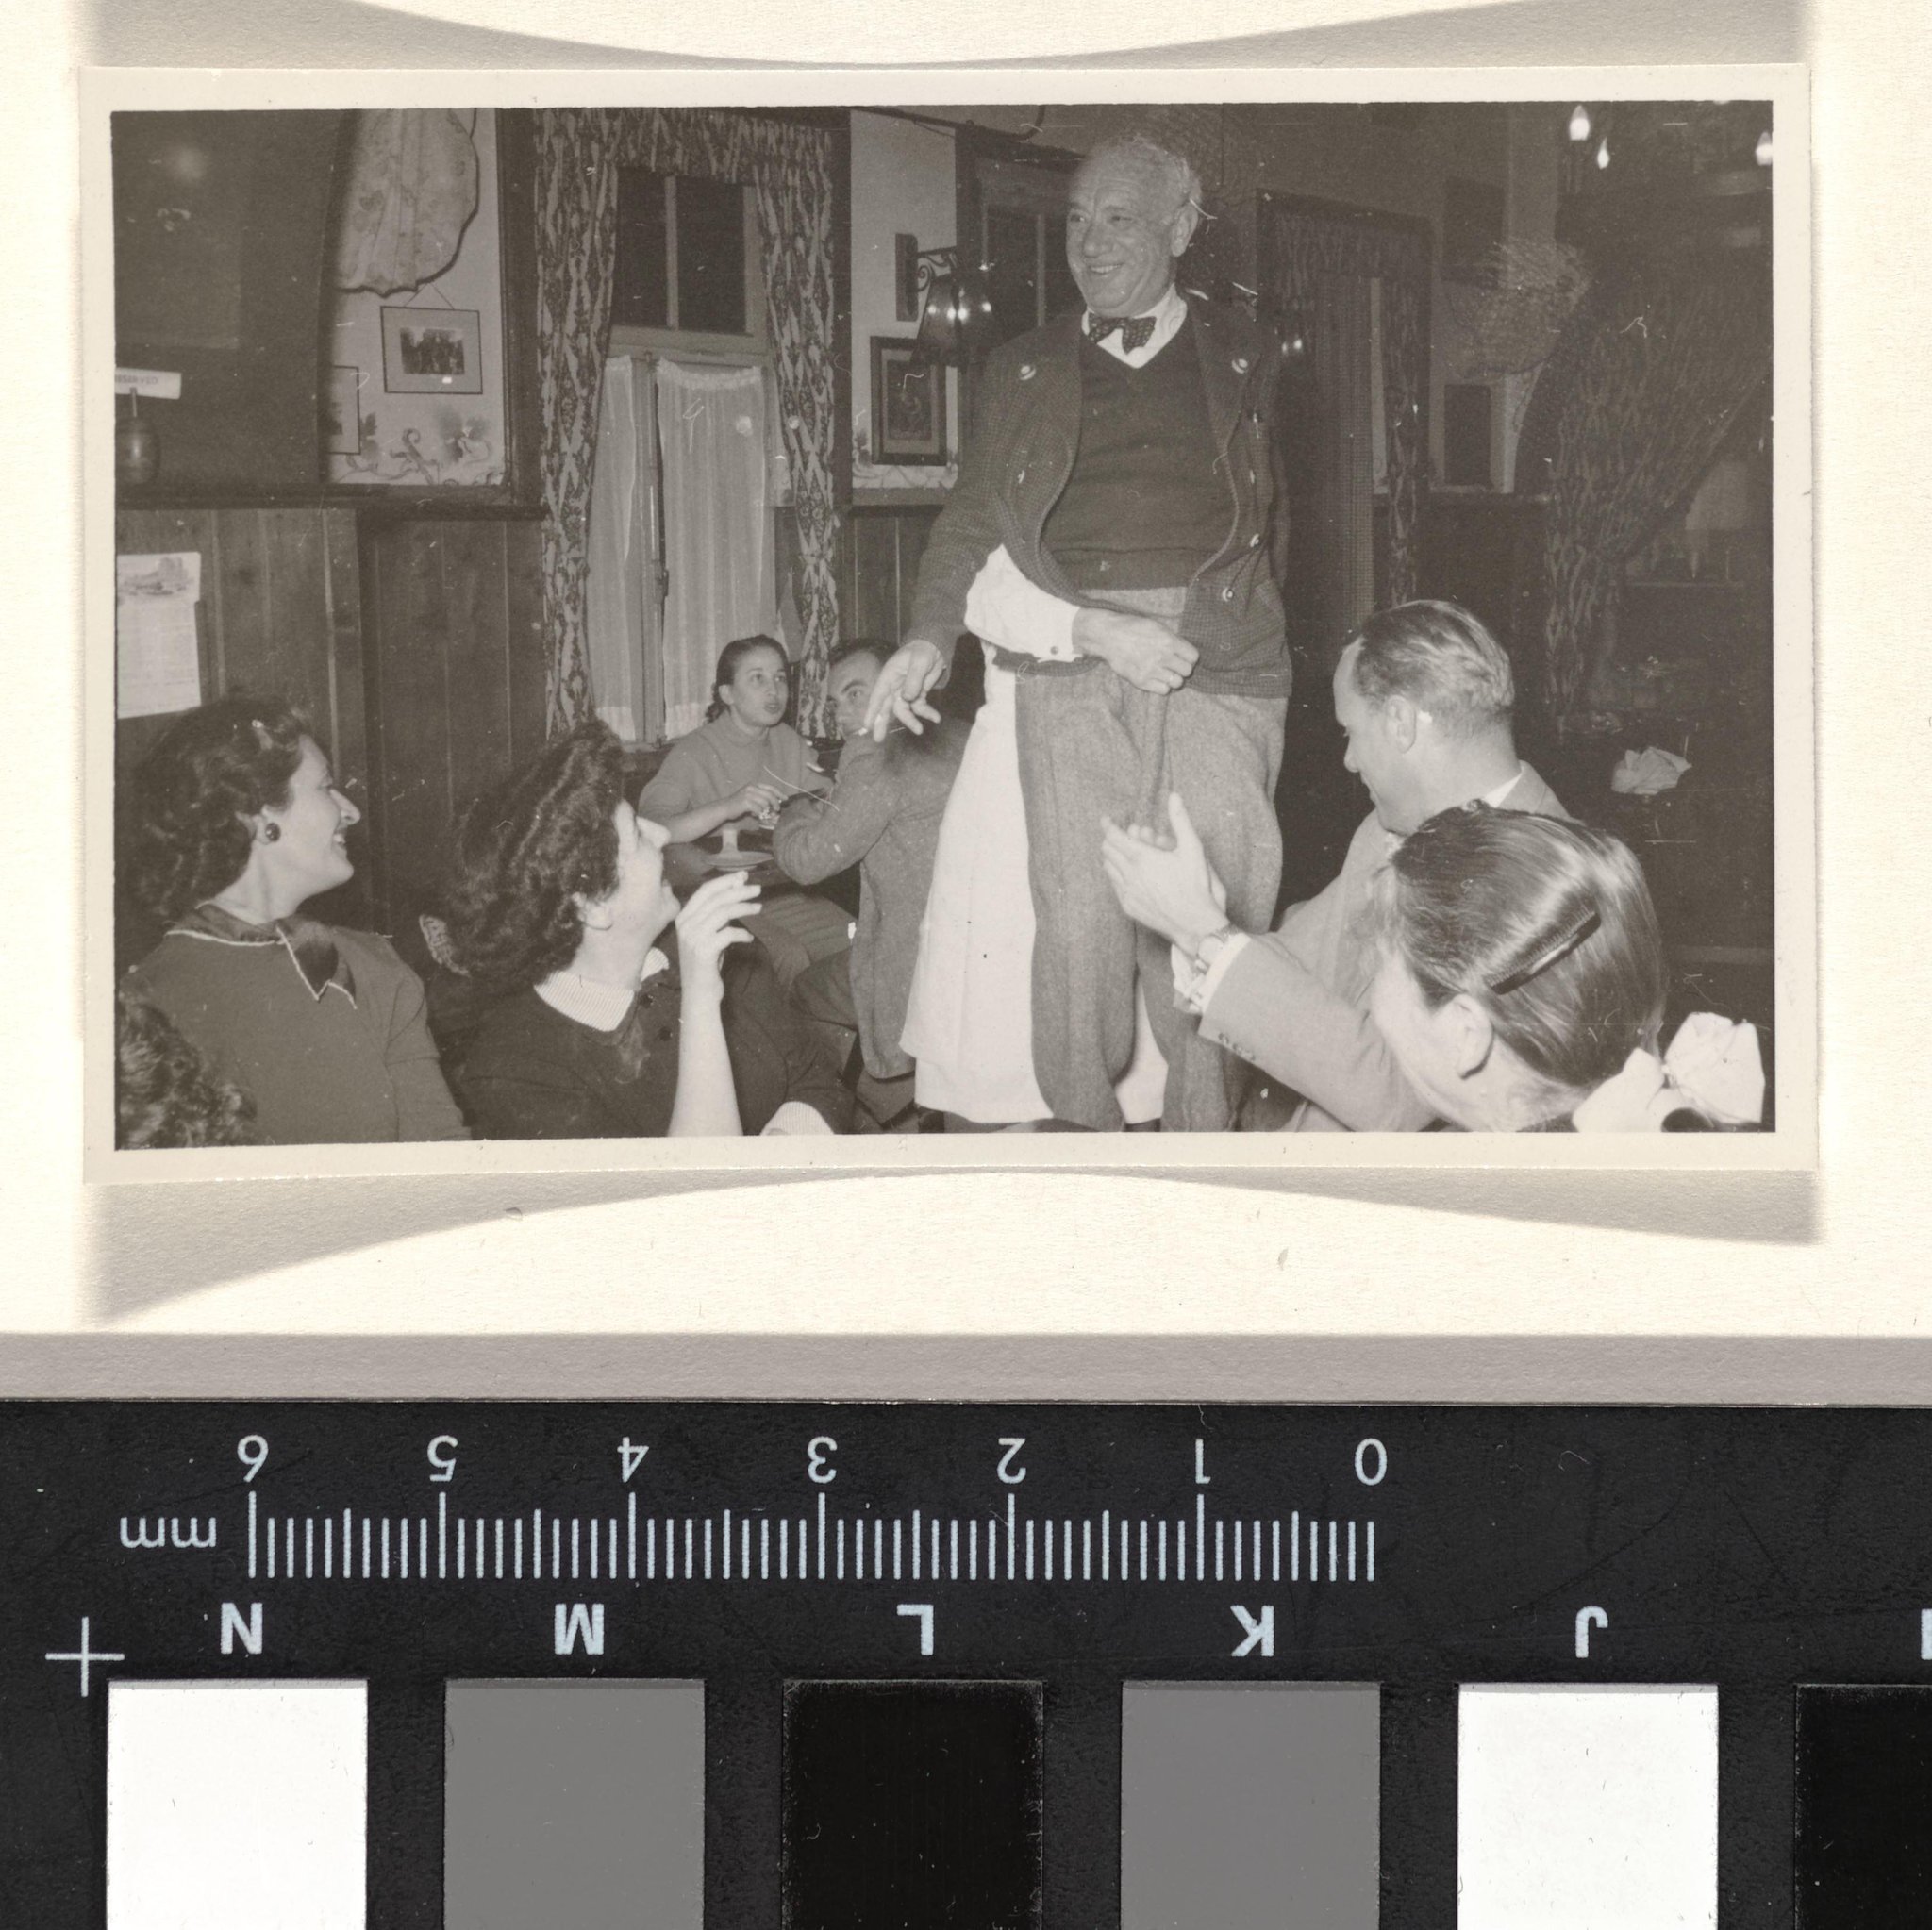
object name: photograph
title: Lachende oudere man opgetild met gezeten klappende man naast zich en twee gezeten vrouwen die naar hem kijken, tijdens een feestelijke aangelegenheid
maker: Anonymous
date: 1950-1970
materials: photographic support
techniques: gelatin silver print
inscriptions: number: ‘1925/26’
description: Lachende oudere man opgetild met gezeten klappende man naast zich (rechts) en twee gezeten vrouwen (links) die naar hem kijken, tijdens een feestelijke aangelegenheid.